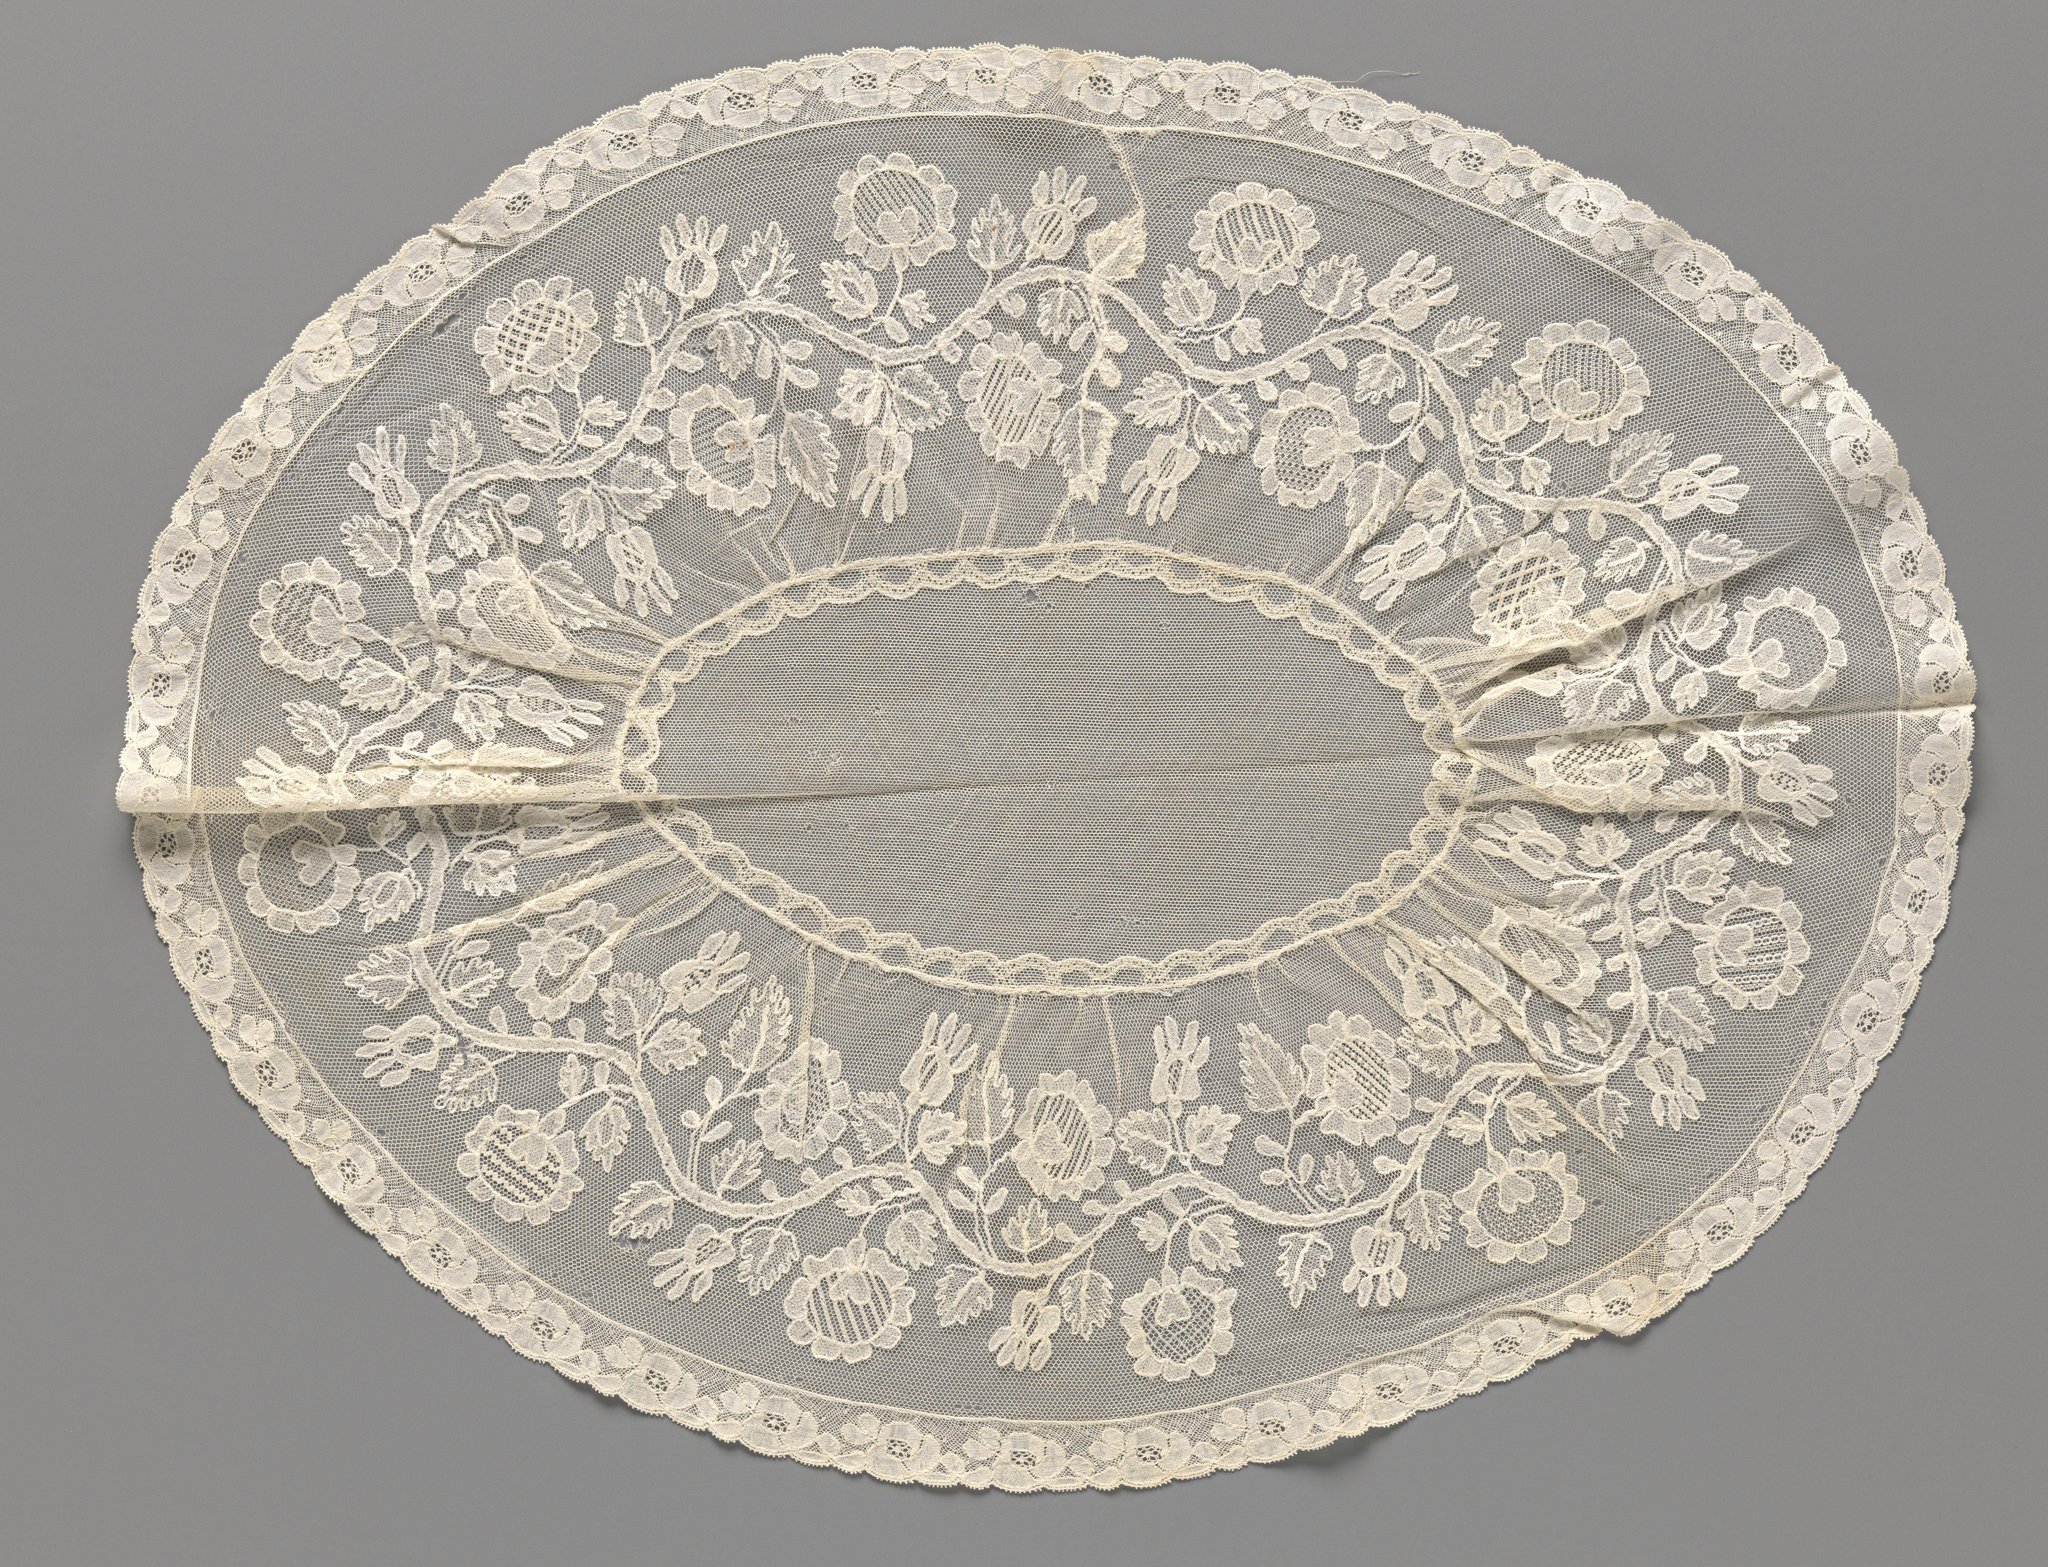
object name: kussendek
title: Kussendek van kantborduurwerk met ovale vorm en golvende rozentak met ovale bloemen en rozenknoppen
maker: Anonymous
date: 1840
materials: linen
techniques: lace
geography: netherlands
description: Kussendek van naturelkleurig kantborduurwerk: tuledoorstopwerk op machinale tule. Ovaal model. Het kussendek heeft een leeg middenovaal met daaraan een smal strookje met boogjes in doorstopwerk. Een brede rand om dit middenveld heen bestaat uit machinale tule waarop in doorstopwerk een regelmatig golvende rozentak is geborduurd met ovale bloemen en rozenknoppen tussen bladeren. In de bloemharten zijn verschillende machinale siergronden toegepast. Rondom is het kussendek afgewerkt met een randje machinale kant met roosjes (imitatie kloskant).